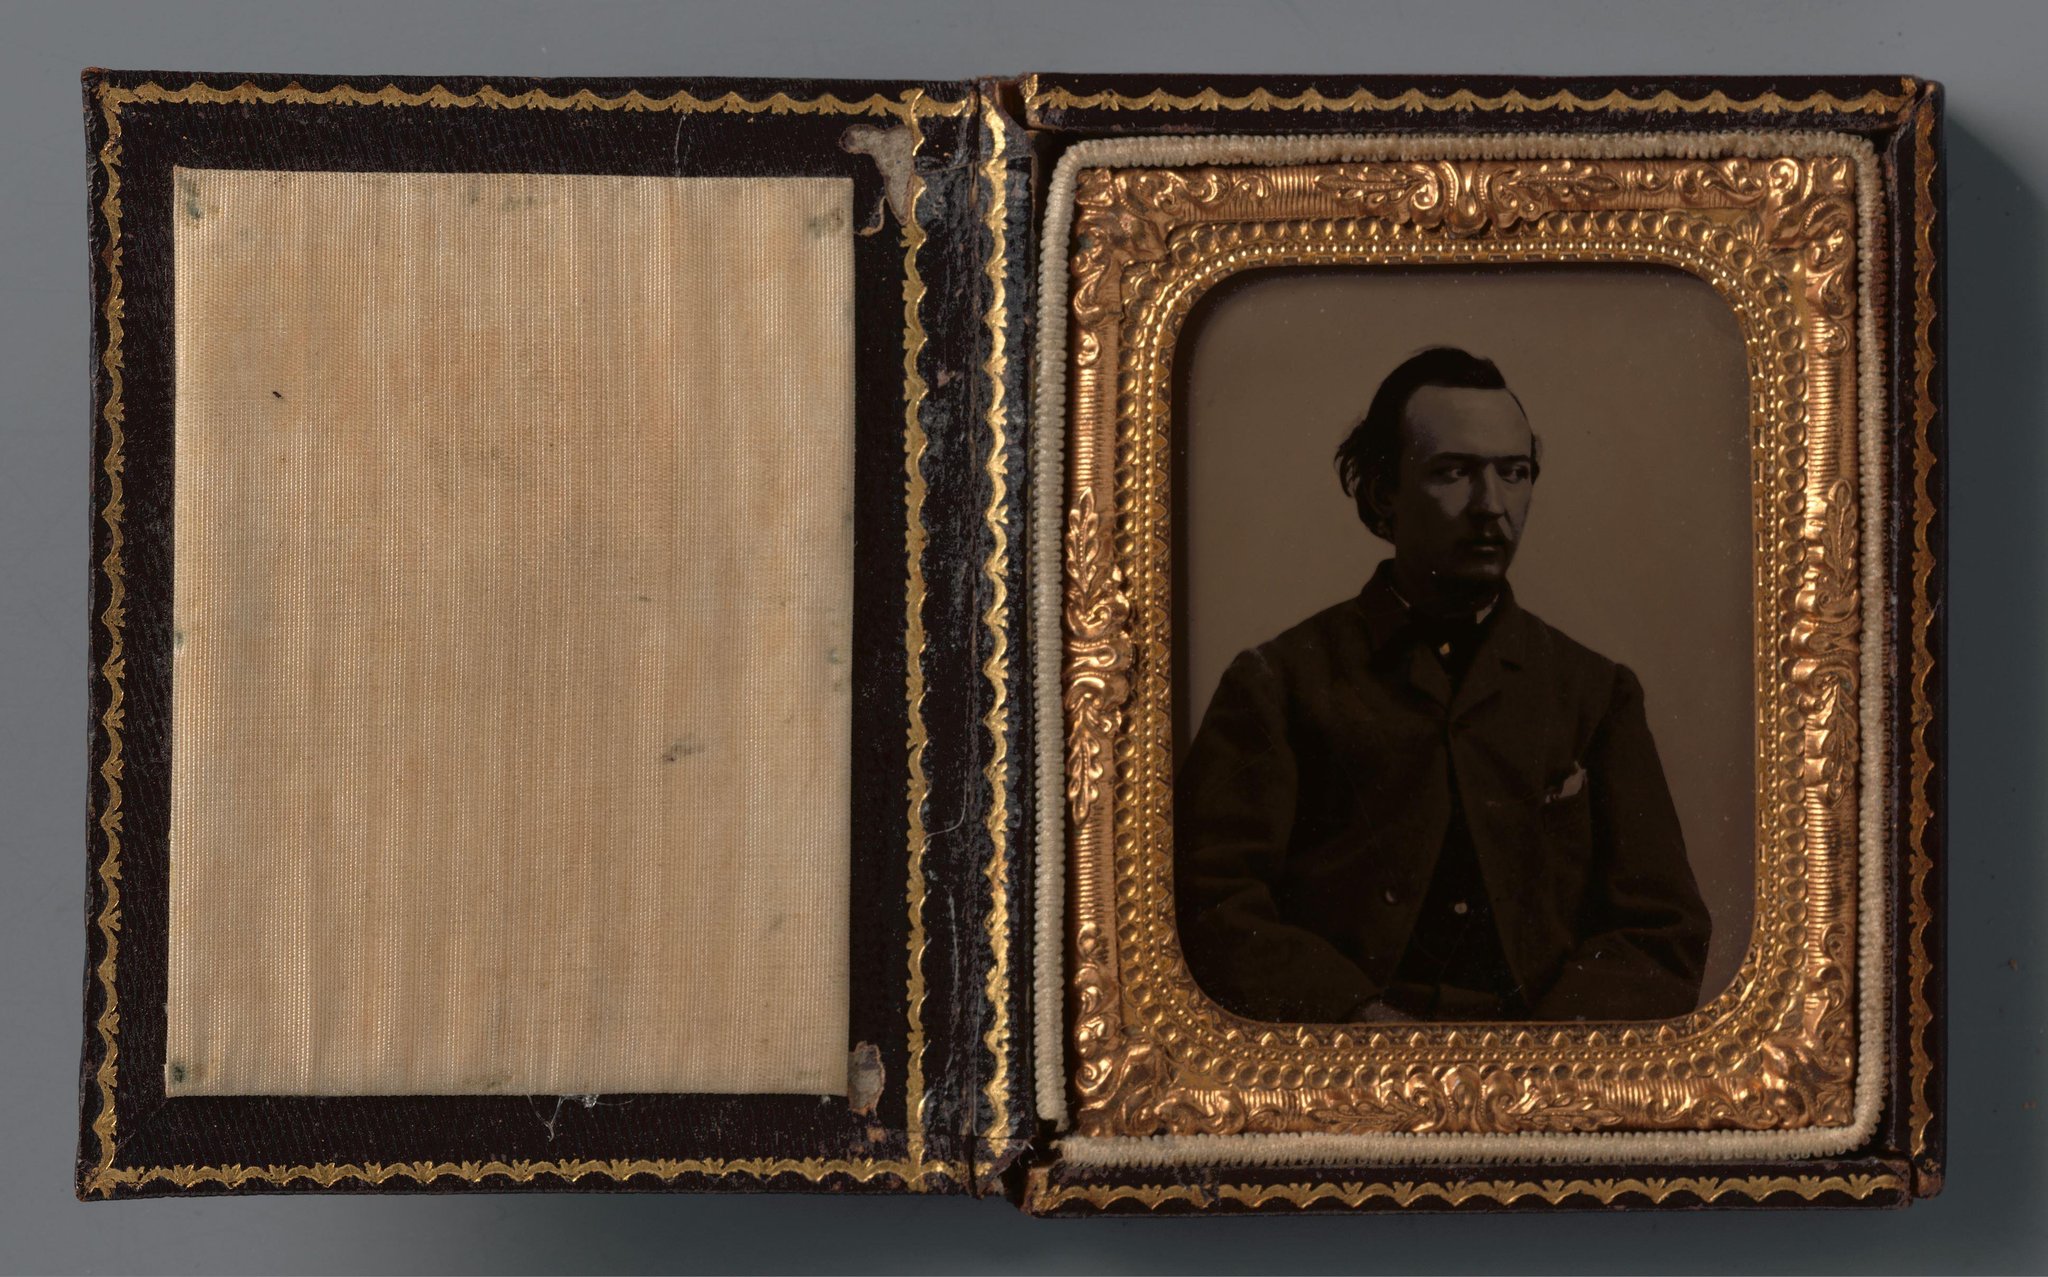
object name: photograph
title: Portret van een onbekende man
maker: Anonymous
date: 1855-1870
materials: glass, metal, silk, wood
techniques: ambrotype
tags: historical persons